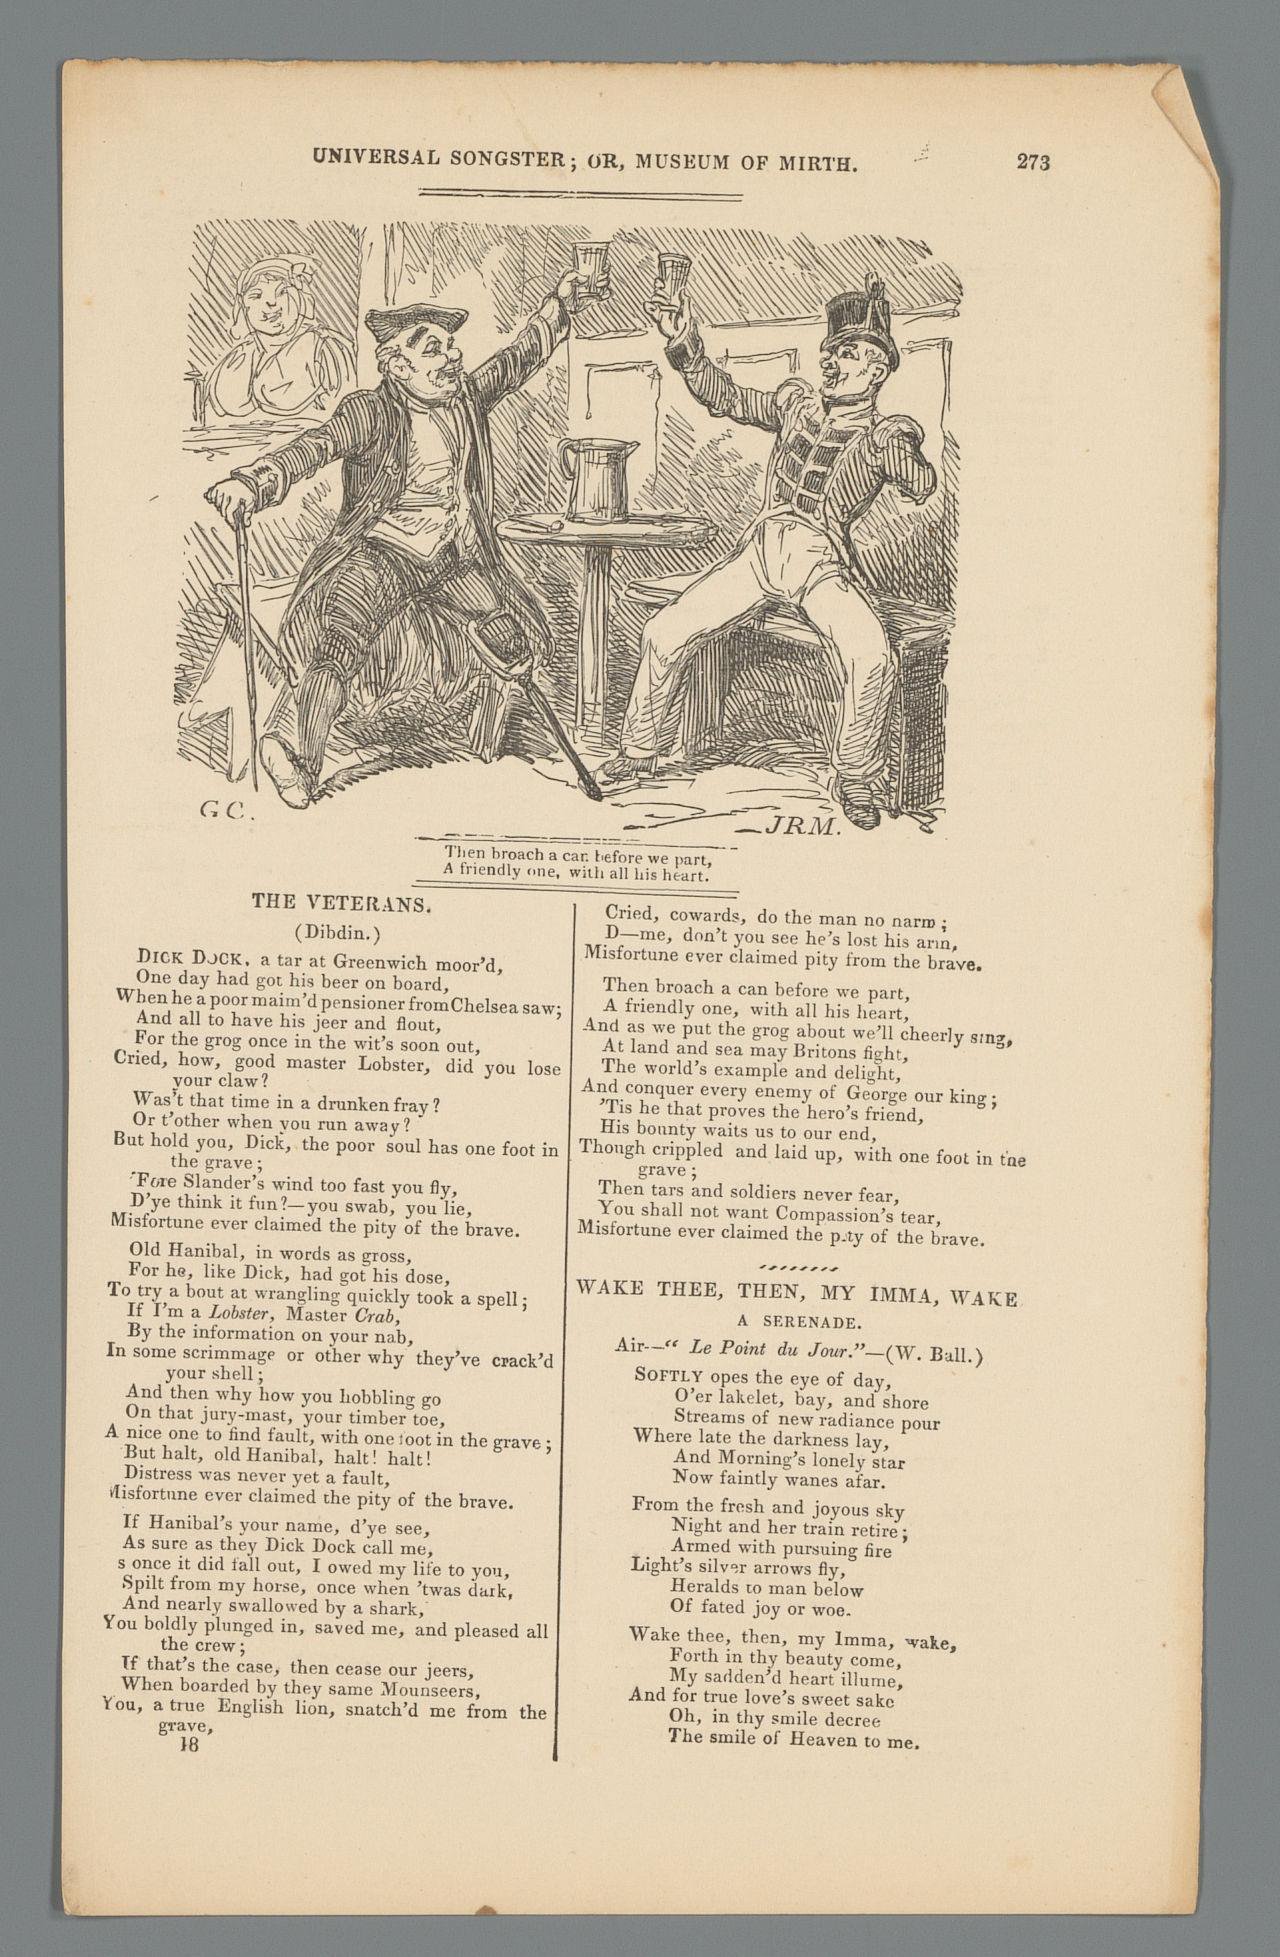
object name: book illustration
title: The Veterans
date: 1825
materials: paper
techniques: engraving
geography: london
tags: veteran, reunion, memorial gathering (~ veteran soldiers), inn, coffee-house, public house, etc., person with a physical disability, political caricatures and satires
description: Twee veteranen, een 'Greenwich pensioner' met een houten been en een 'Chelsea pensioner' zonder arm drinken samen in een herberg. Spotprent bij een blad met de tekst van het lied: The Veterans. Illustratie (p. 273/274) genomen uit een uitgave van de liederenbundel: The Universal Songster, or Museum of Mirth, vol. I., eerst verschenen in 1825.